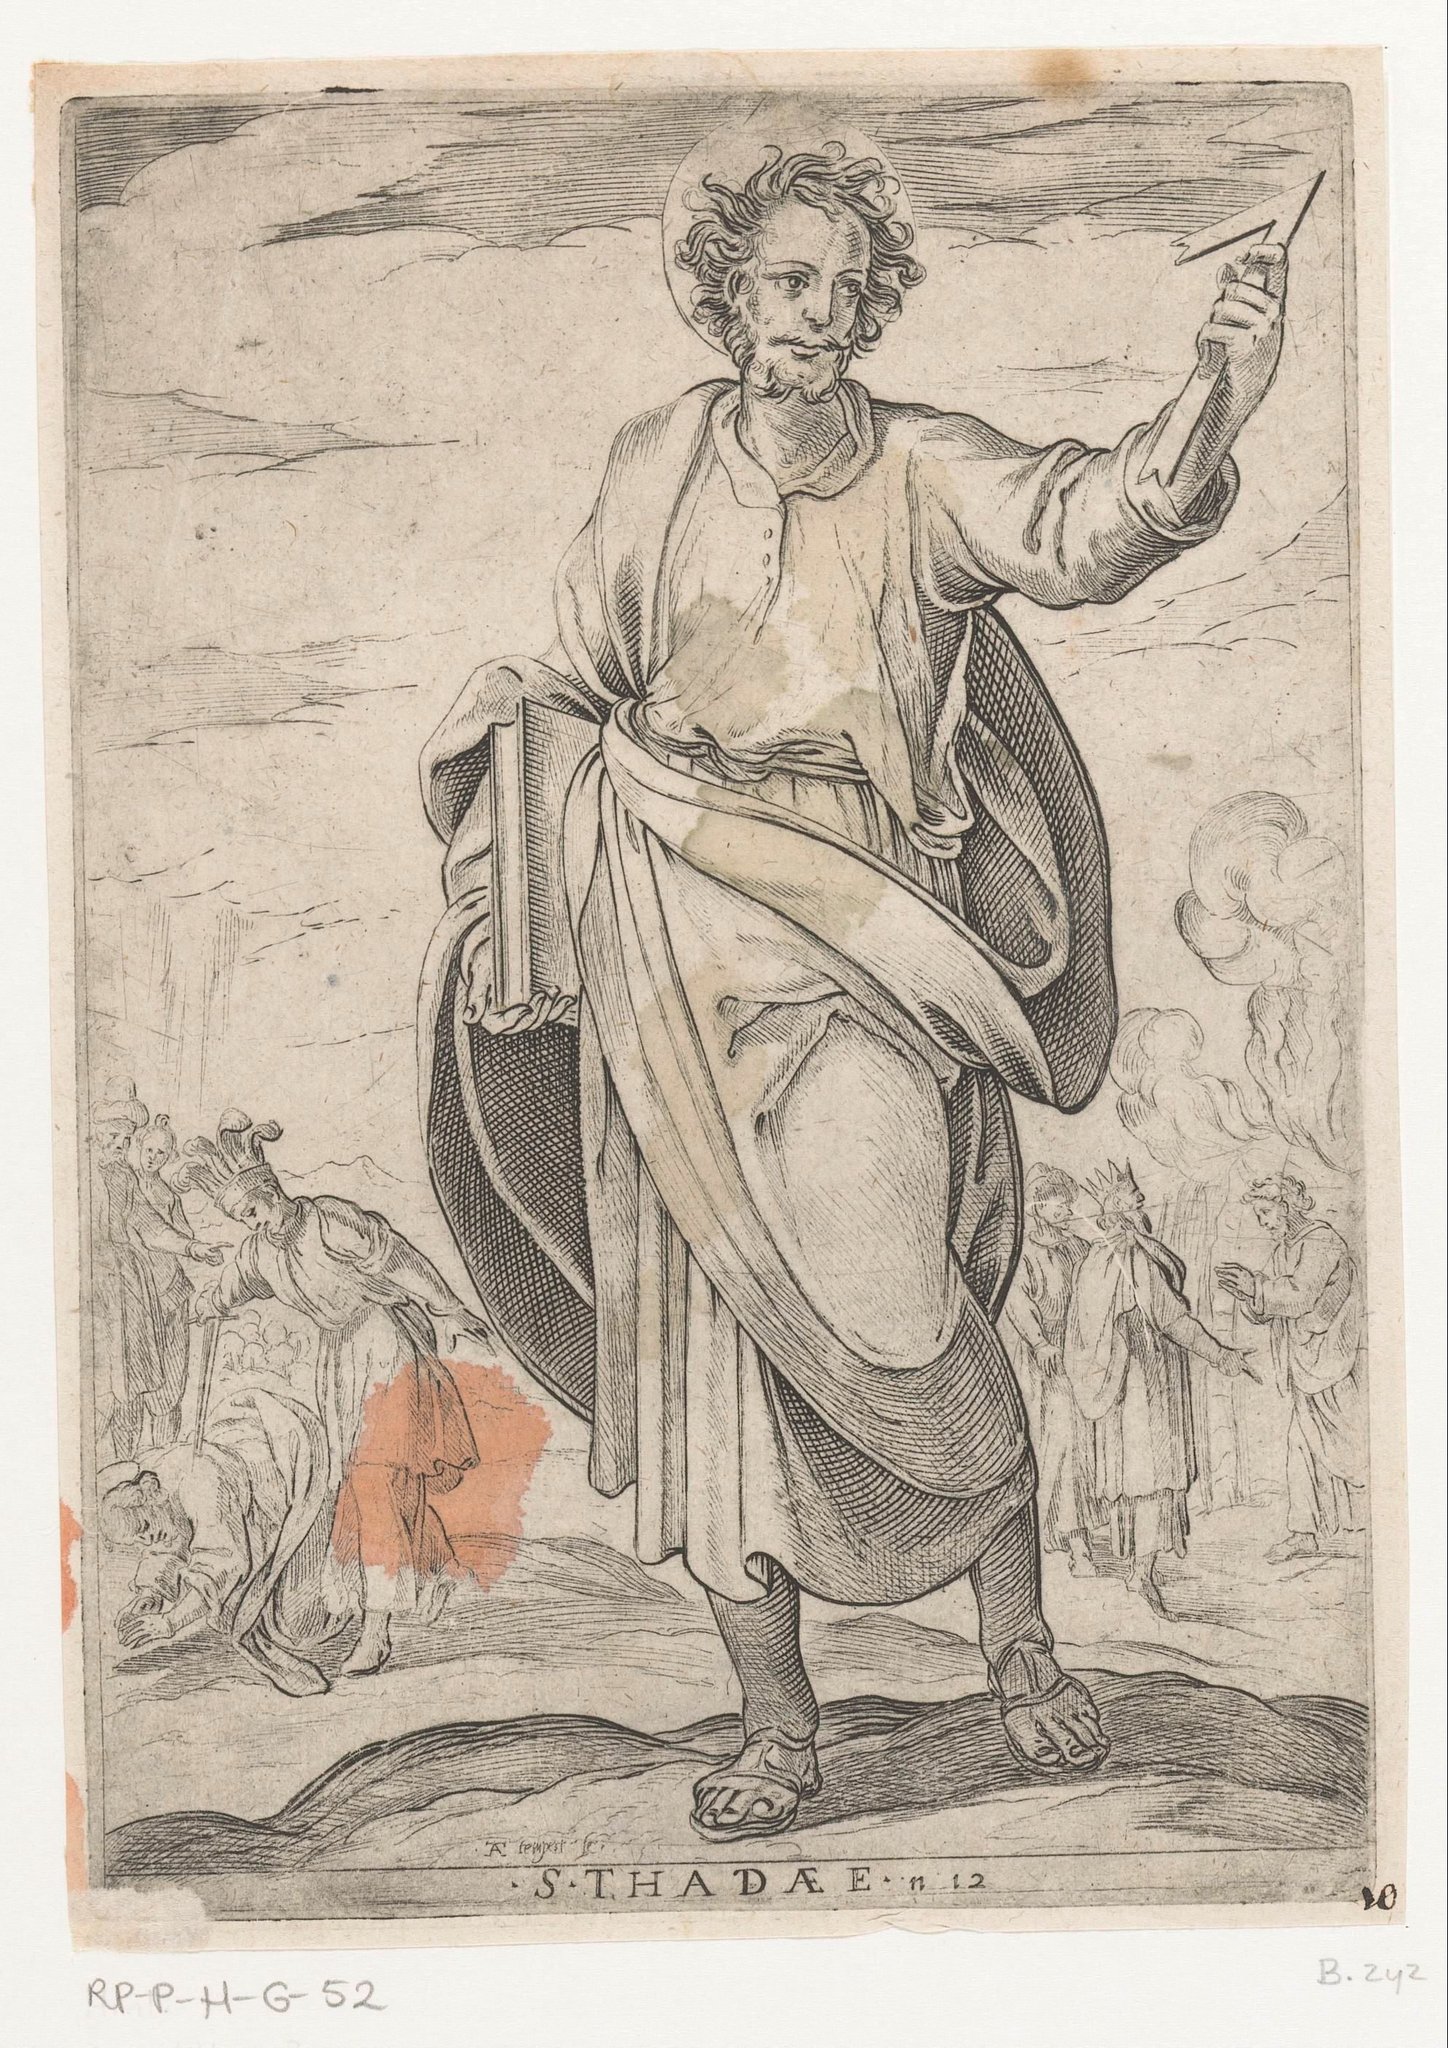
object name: print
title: S. Thadae e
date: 1565-1630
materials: paper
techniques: etching, intaglio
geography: italy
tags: the apostle jude thaddaeus; possible attributes: book, club, halberd, scroll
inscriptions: collector's mark: ‘Hinloopen’, collector's mark: Lugt 11, number: ‘10’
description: De heilige Judas Taddeüs met winkelhaak en boek. Op de achtergrond links wordt Judas gedood door een man met een zwaard. Op de achtergrond rechts is Judas in gesprek met koning Abagarus.